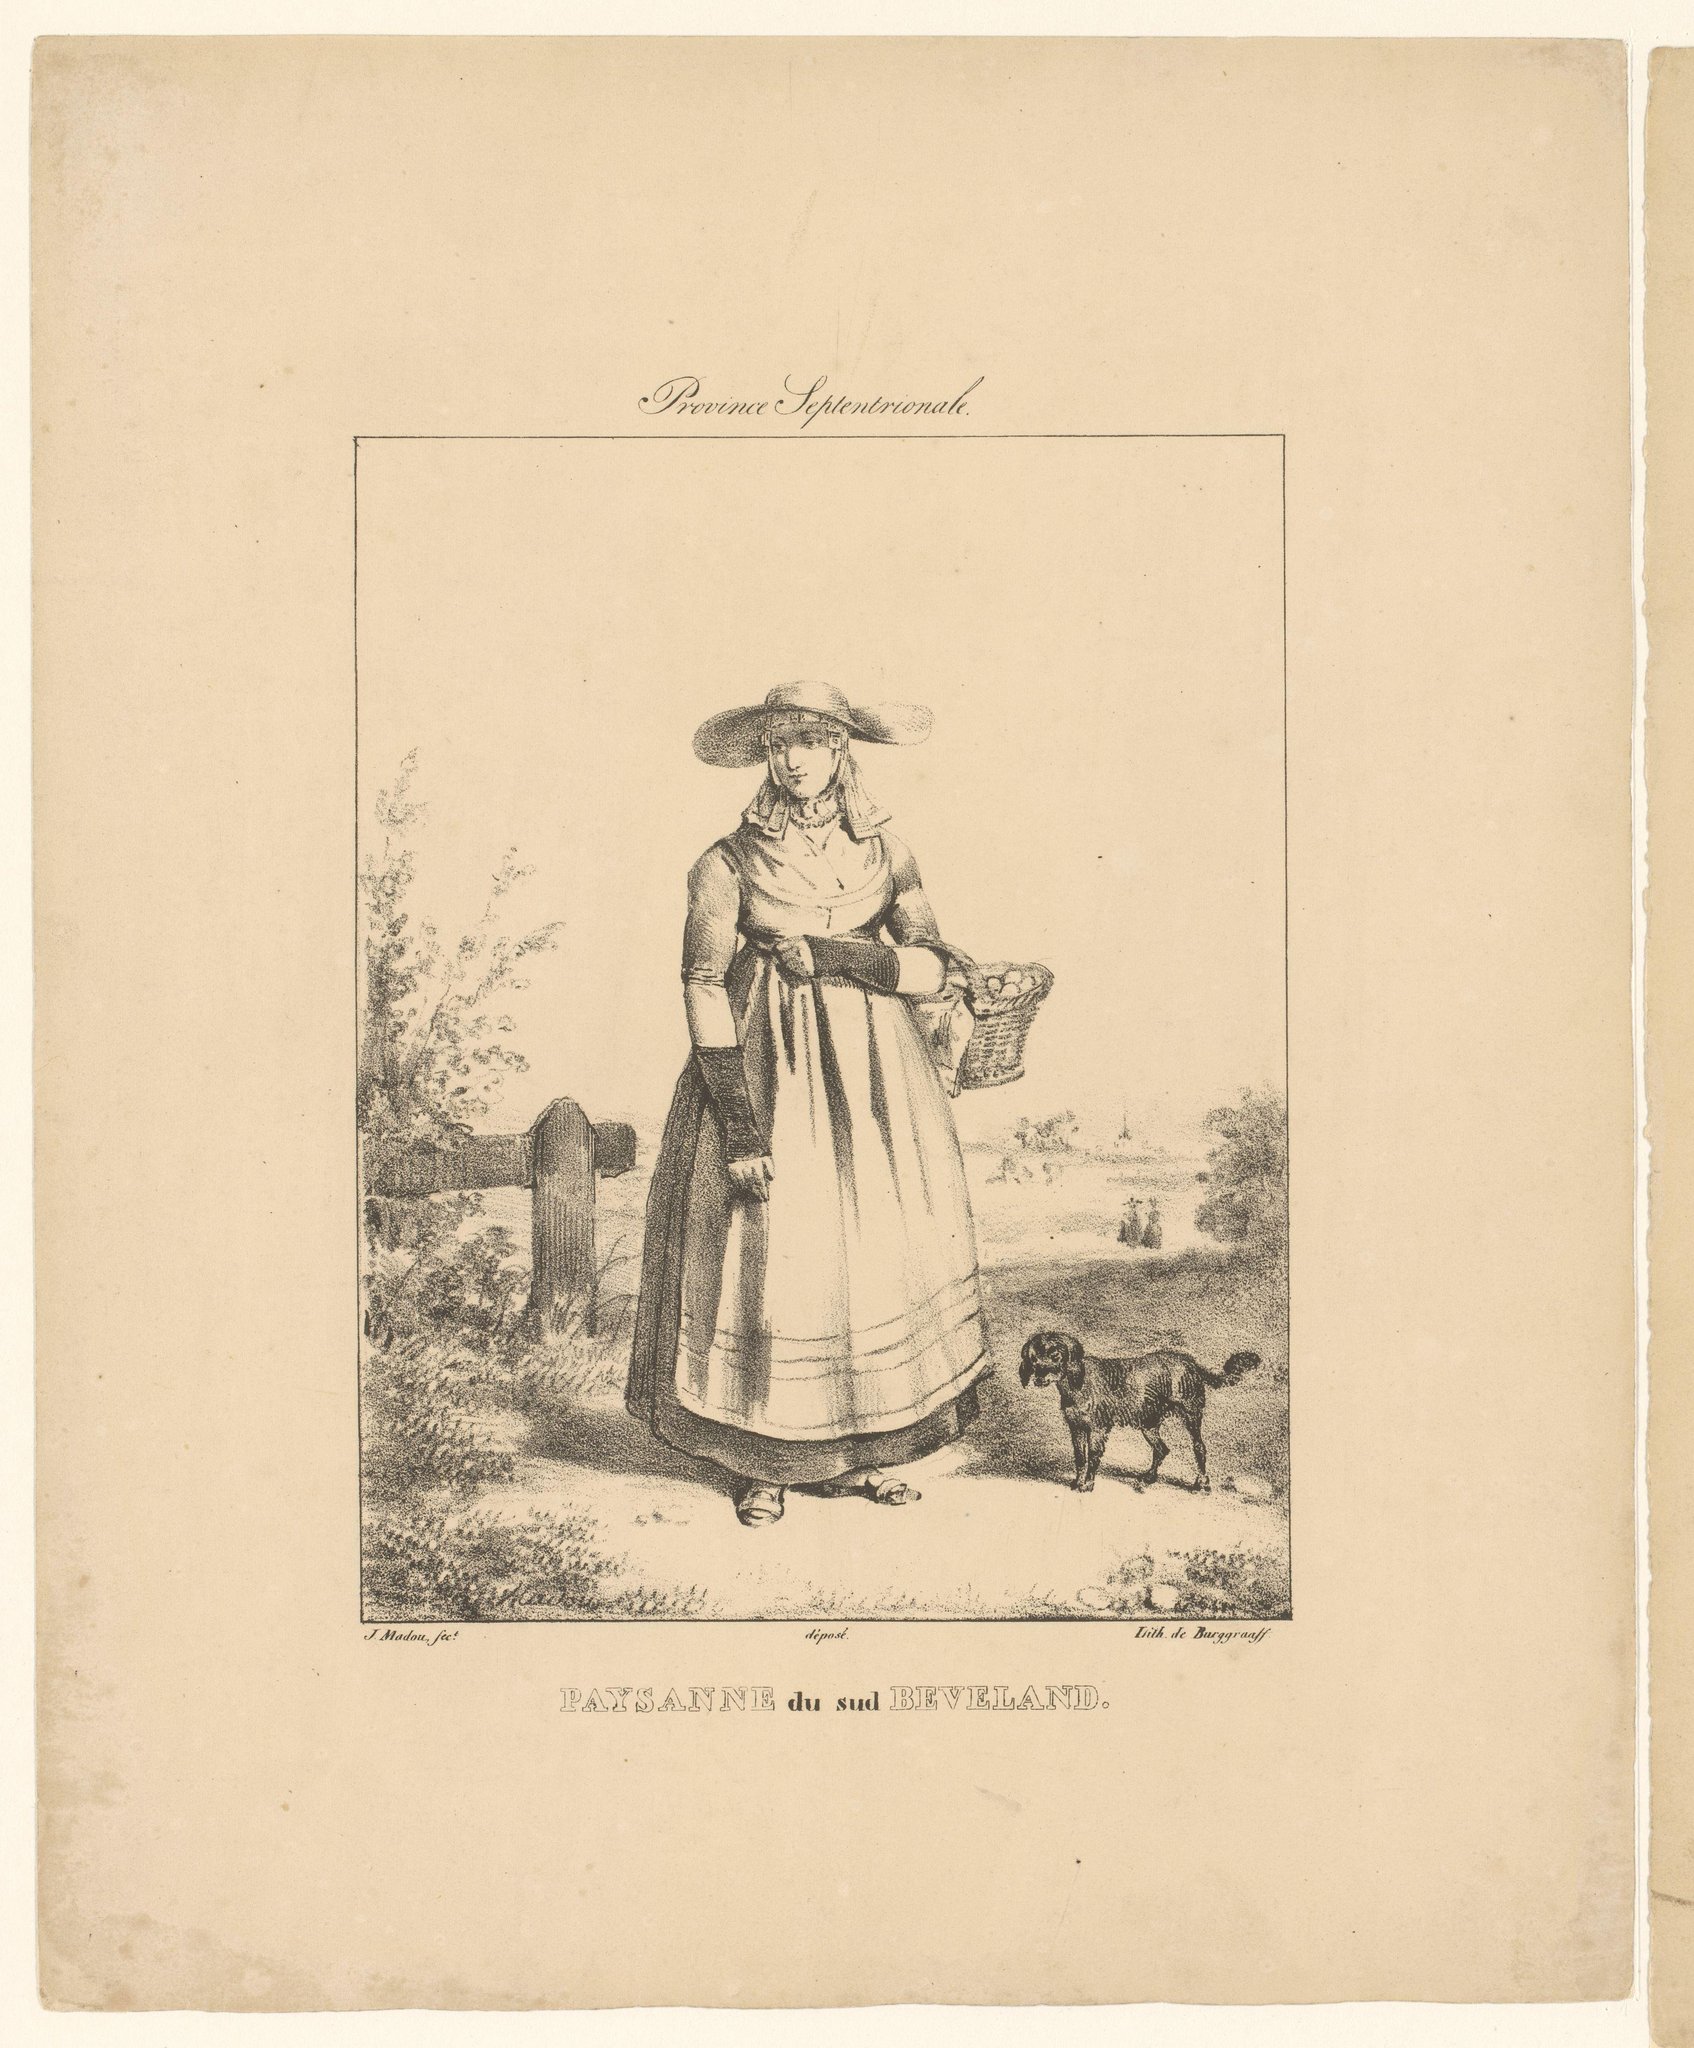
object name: print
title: Kostuums van de inwoners van Nederland en België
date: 1825-1835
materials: paper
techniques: lithograph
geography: brussels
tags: adult woman, carrying something in basket, bag, rucksack, etc., folk costume, regional costume, dog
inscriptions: : ‘Déposé’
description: Van den Burggraaff wilde een serie (twintig afleveringen met telkens vier platen) uitgeven met kostuums uit alle provincies van Nederland en België onder de titel 'Costumes du peuple de toutes les provinces des Pays-Bas'. Hij begint met deze serie in 1825 en eindigt hiermee bij de dertiende aflevering in 1830. Omdat in 1830 België zicht afsplitst van Nederland geeft hij de prenten daarna apart uit onder de titels 'Costumes de peuple Hollandais' en 'Collection de costumes du peuple des provinces de la Belgique' (1835).